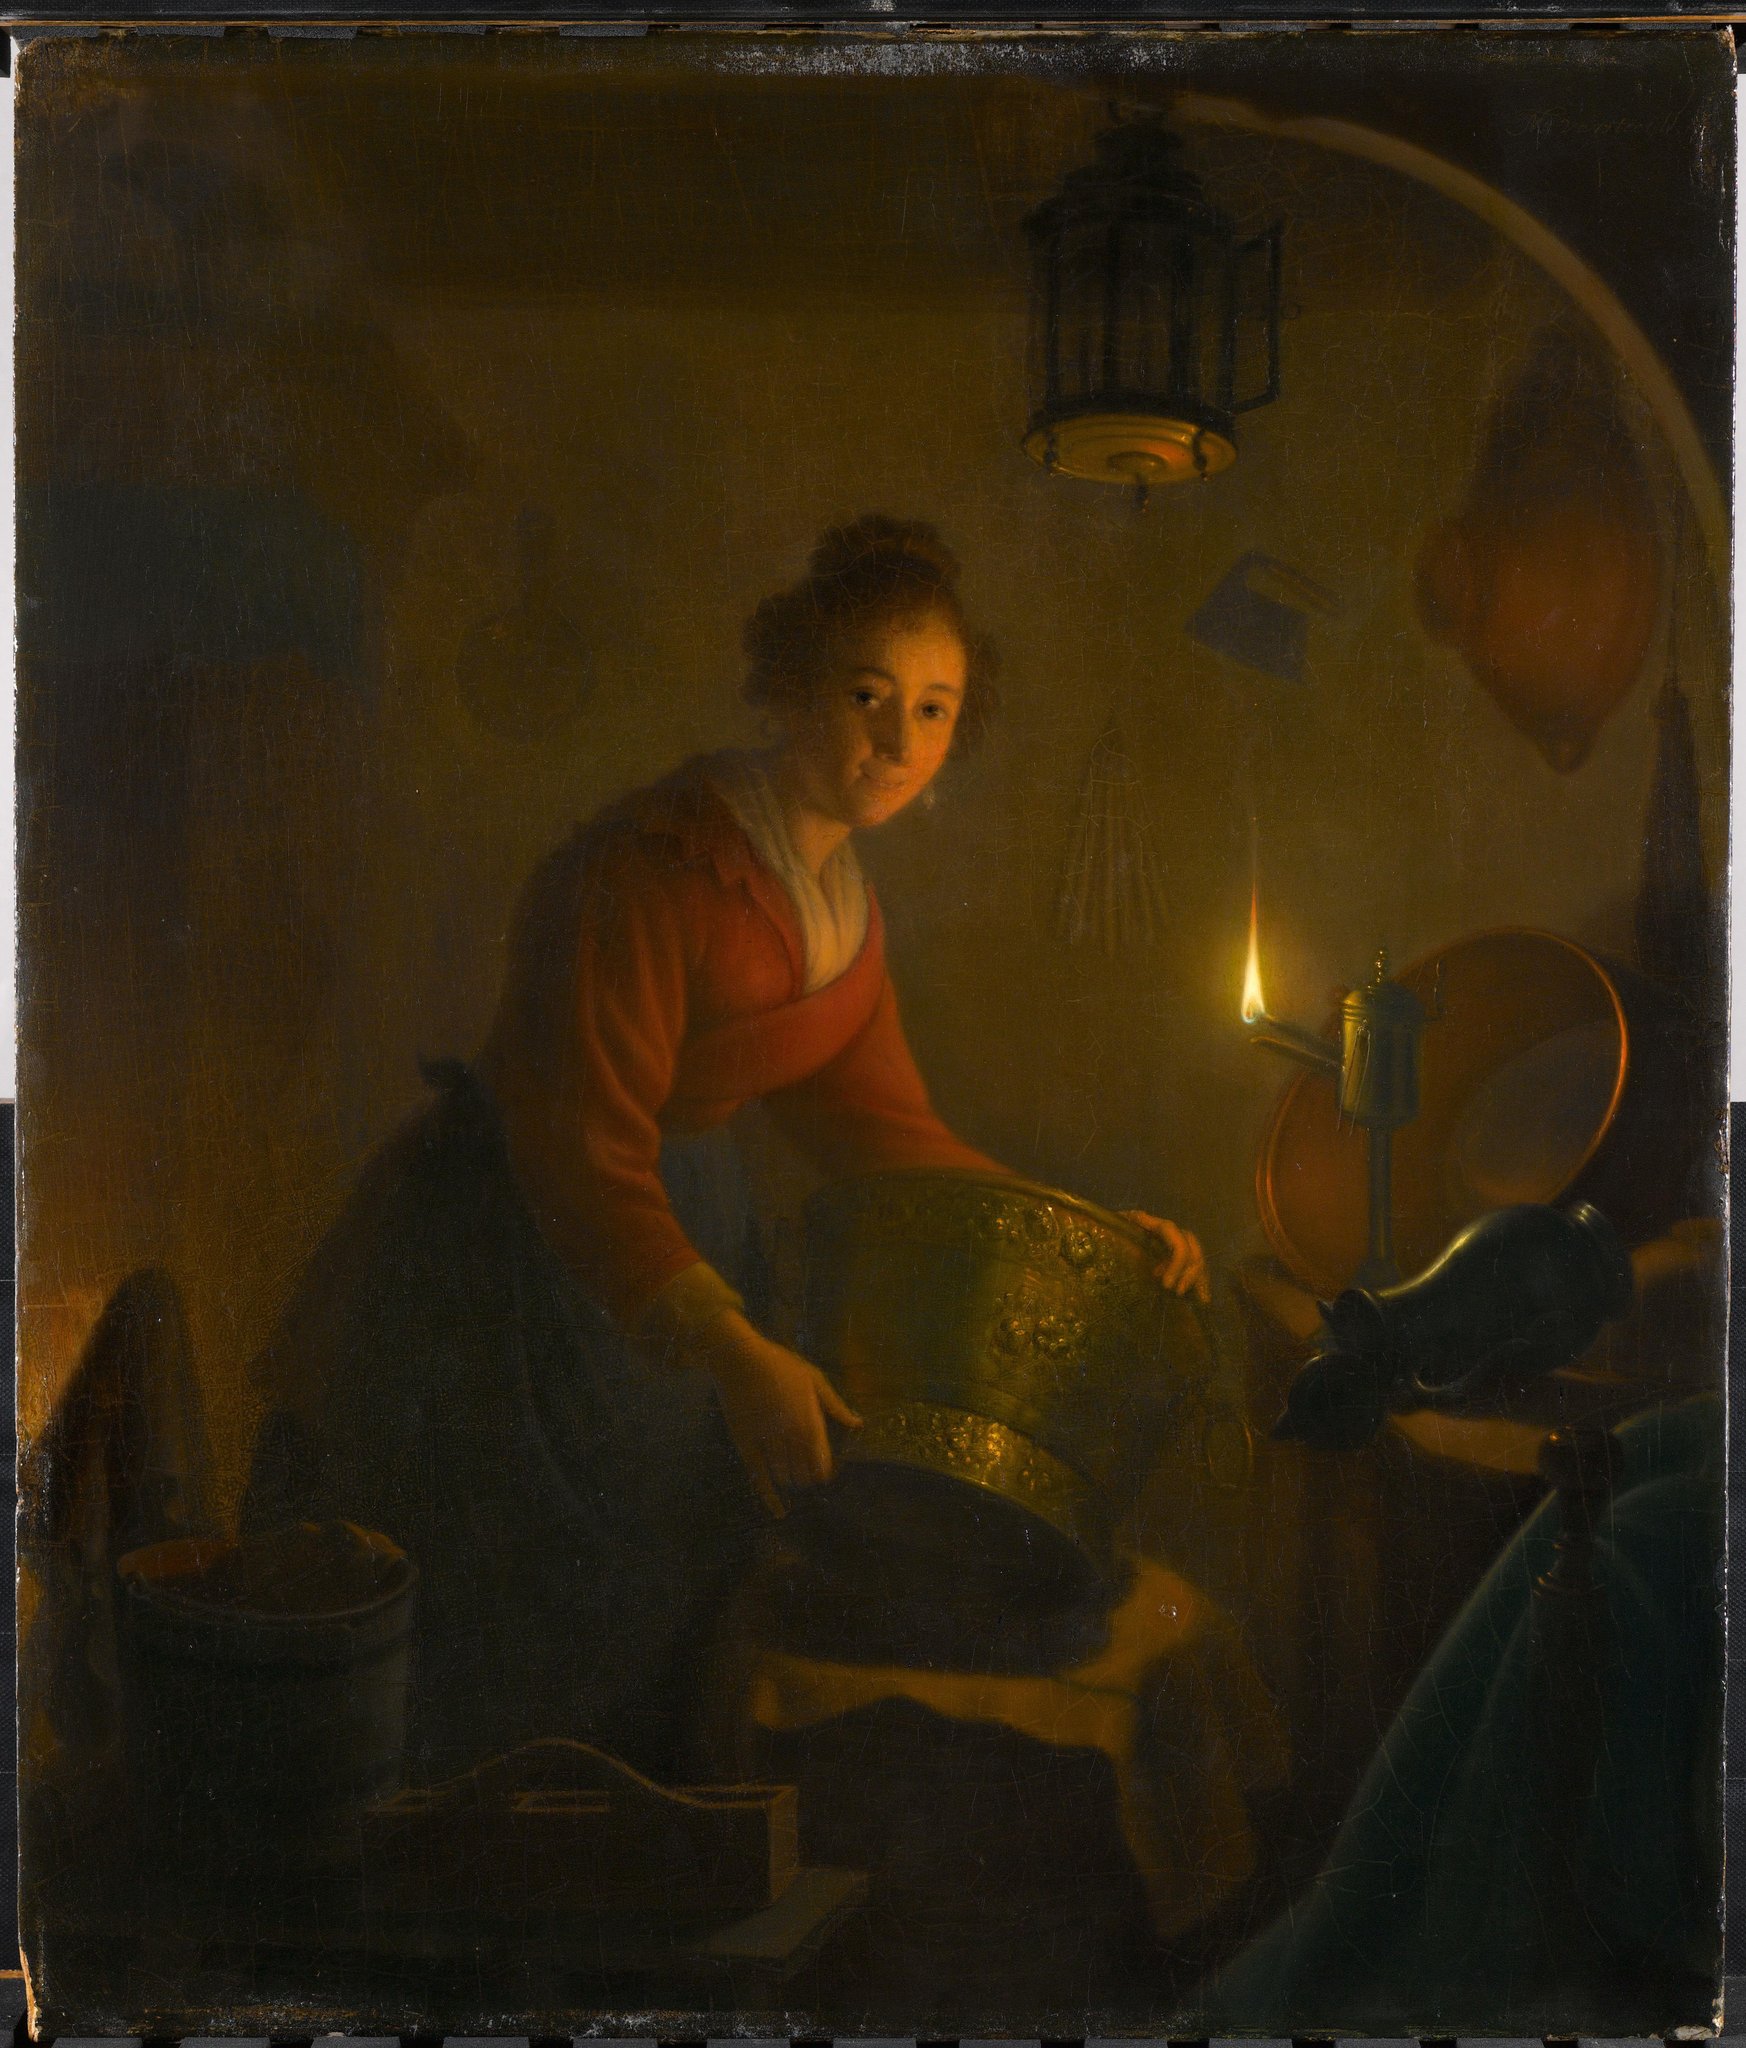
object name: painting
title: A Woman in a Kitchen by Candlelight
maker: michiel versteegh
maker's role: painter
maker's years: 1756-1843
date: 1830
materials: oil, paint, panel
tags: oil-lamp, kitchen-utensils (with name), kitchen-maid, kitchen servant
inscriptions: signature: ‘M. Versteegh fecit’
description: Een vrouw in een keuken bij het licht van een olielamp. Een dienstmeid is bij het licht van een olielampje koperen pannen en ketels aan het schuren.